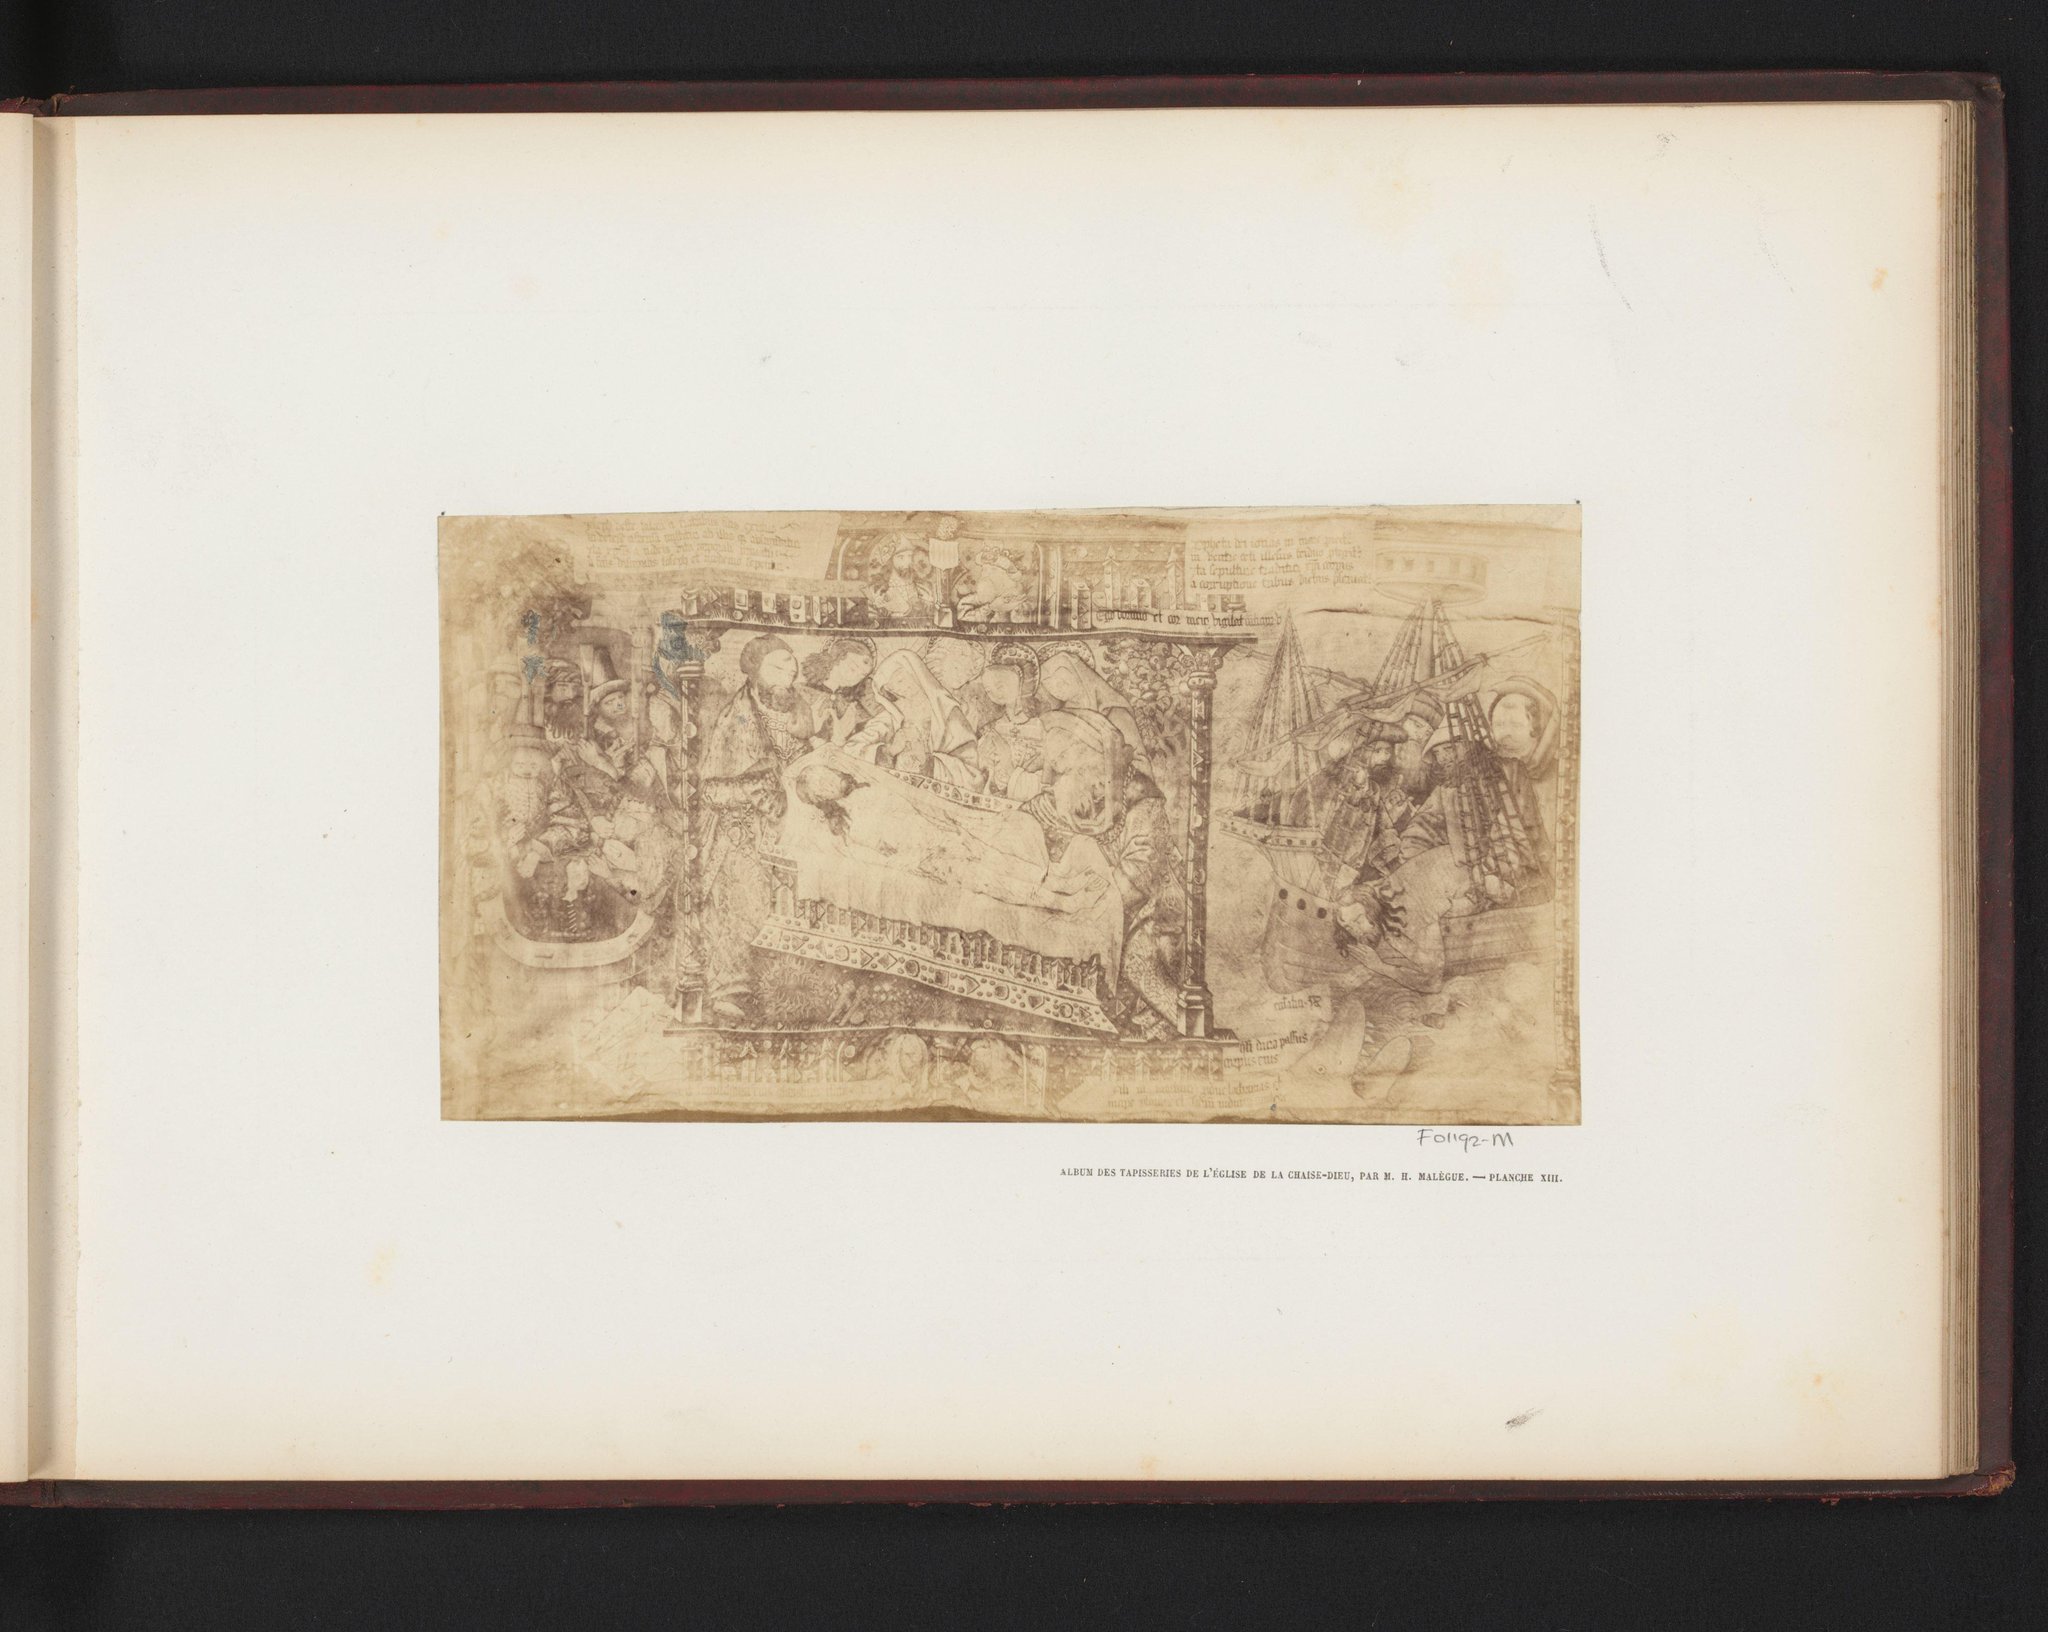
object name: page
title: Tapijt met de graflegging van Christus en prefiguraties in een kerk te La Chaise-Dieu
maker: hippolyte malègue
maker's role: archeoloog, fotograaf, schrijver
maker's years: 1825-1901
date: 1868-1873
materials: photographic support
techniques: albumen print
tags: christ's entombment (possibly by angels), tapestry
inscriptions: inscription: ‘album des tapisseries de l'église de la Chaise-Dieu, par M. H. Malegue - Planche XIII’